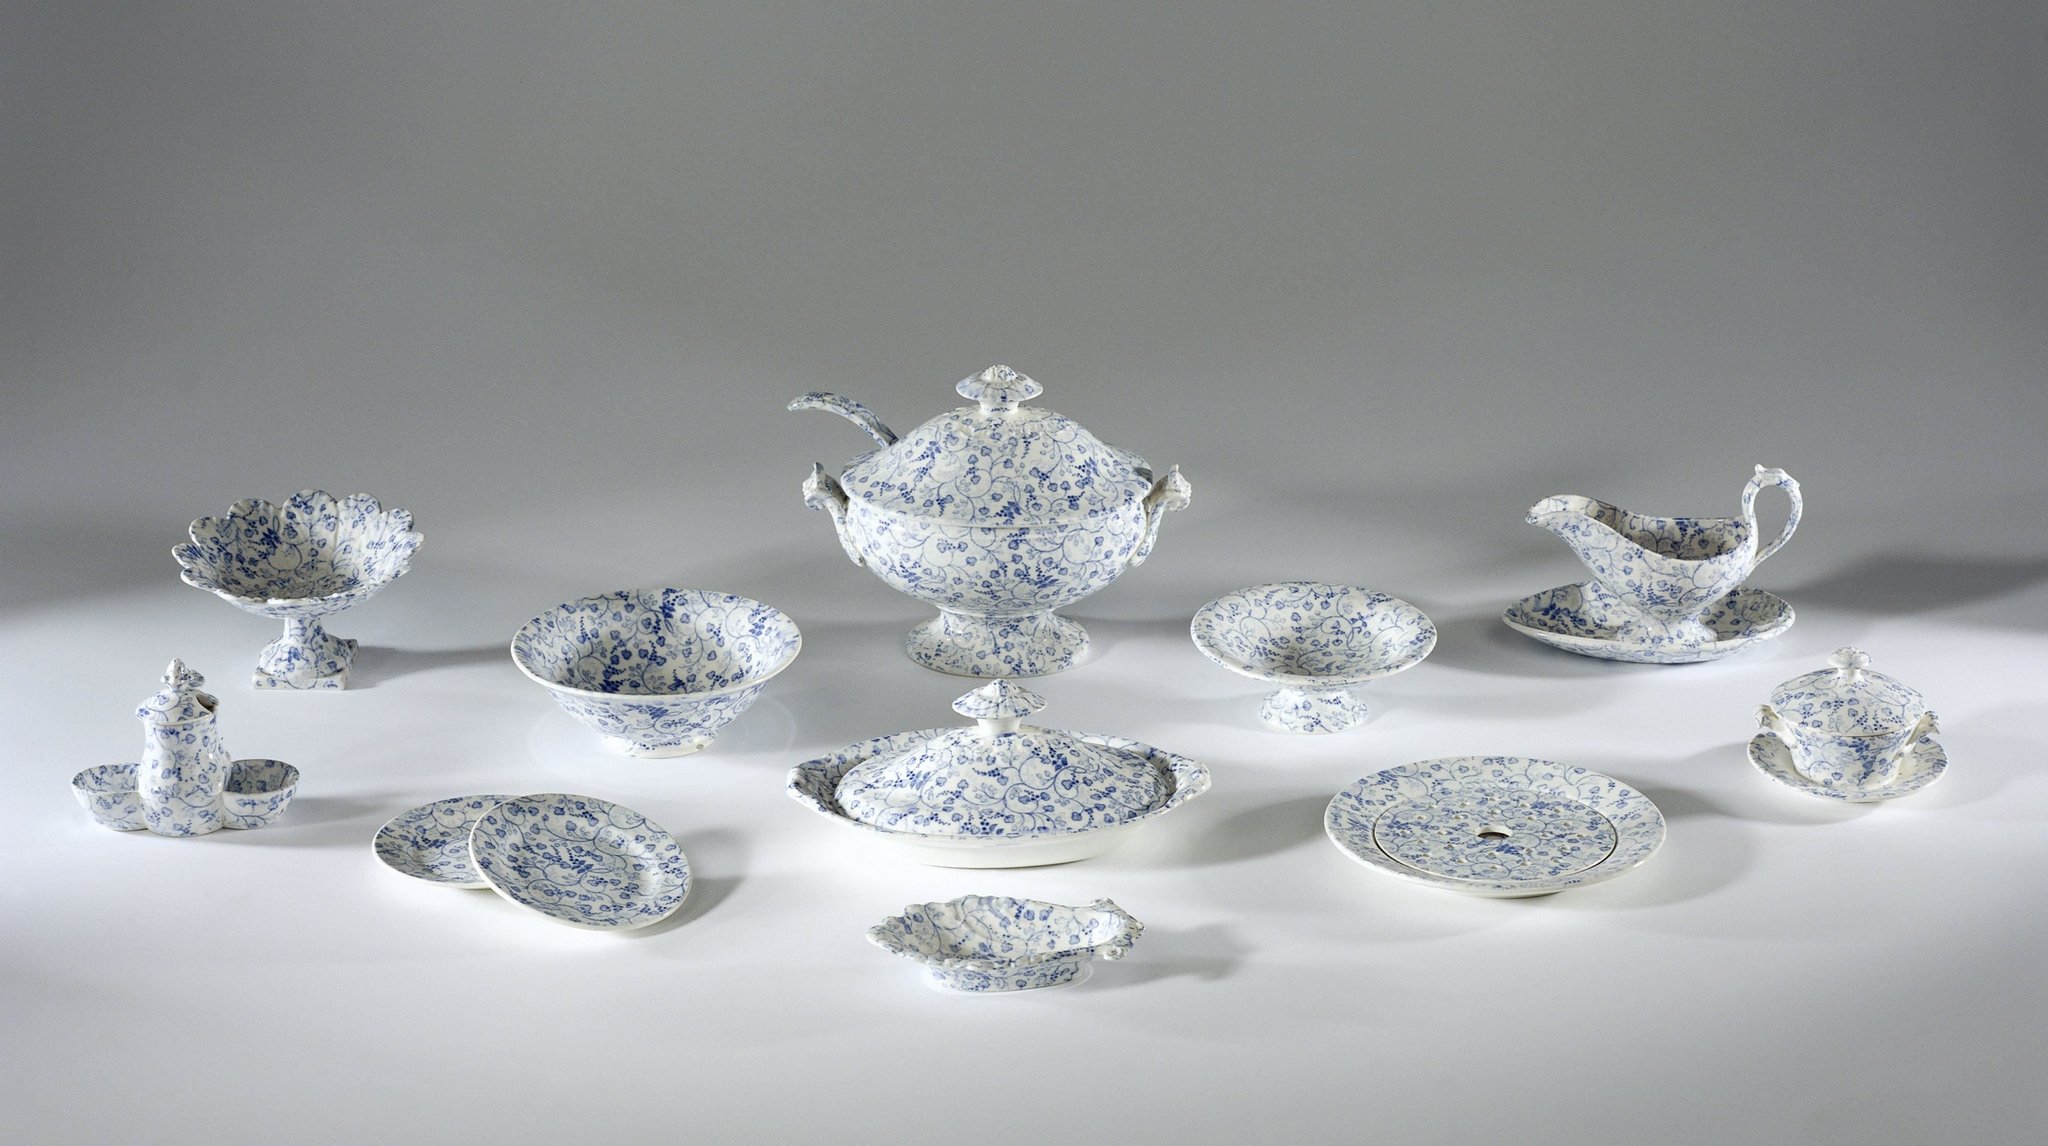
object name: kinderservies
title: Kinderservies met blauw doorlopend bloemendecor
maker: petrus regout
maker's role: plateelbakker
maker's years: 1801-1879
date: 1867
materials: creamware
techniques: transfer decoration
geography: maastricht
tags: maastricht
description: Kinderservies Petrus Regout & Co, Maastricht, 1867 In de fabrieken van Petrus Regout waren veel kinderen werkzaam. Tijdens de arbeidsenquête van 1861 wilde hij geen informatie verschaffen over het precieze aantal kinderen in zijn fabrieken. Van de 1400 arbeiders waren er waarschijnlijk 250 tot 300 jonger dan twaalf. De kinderen waren vooral werkzaam in de aardewerkfabriek.